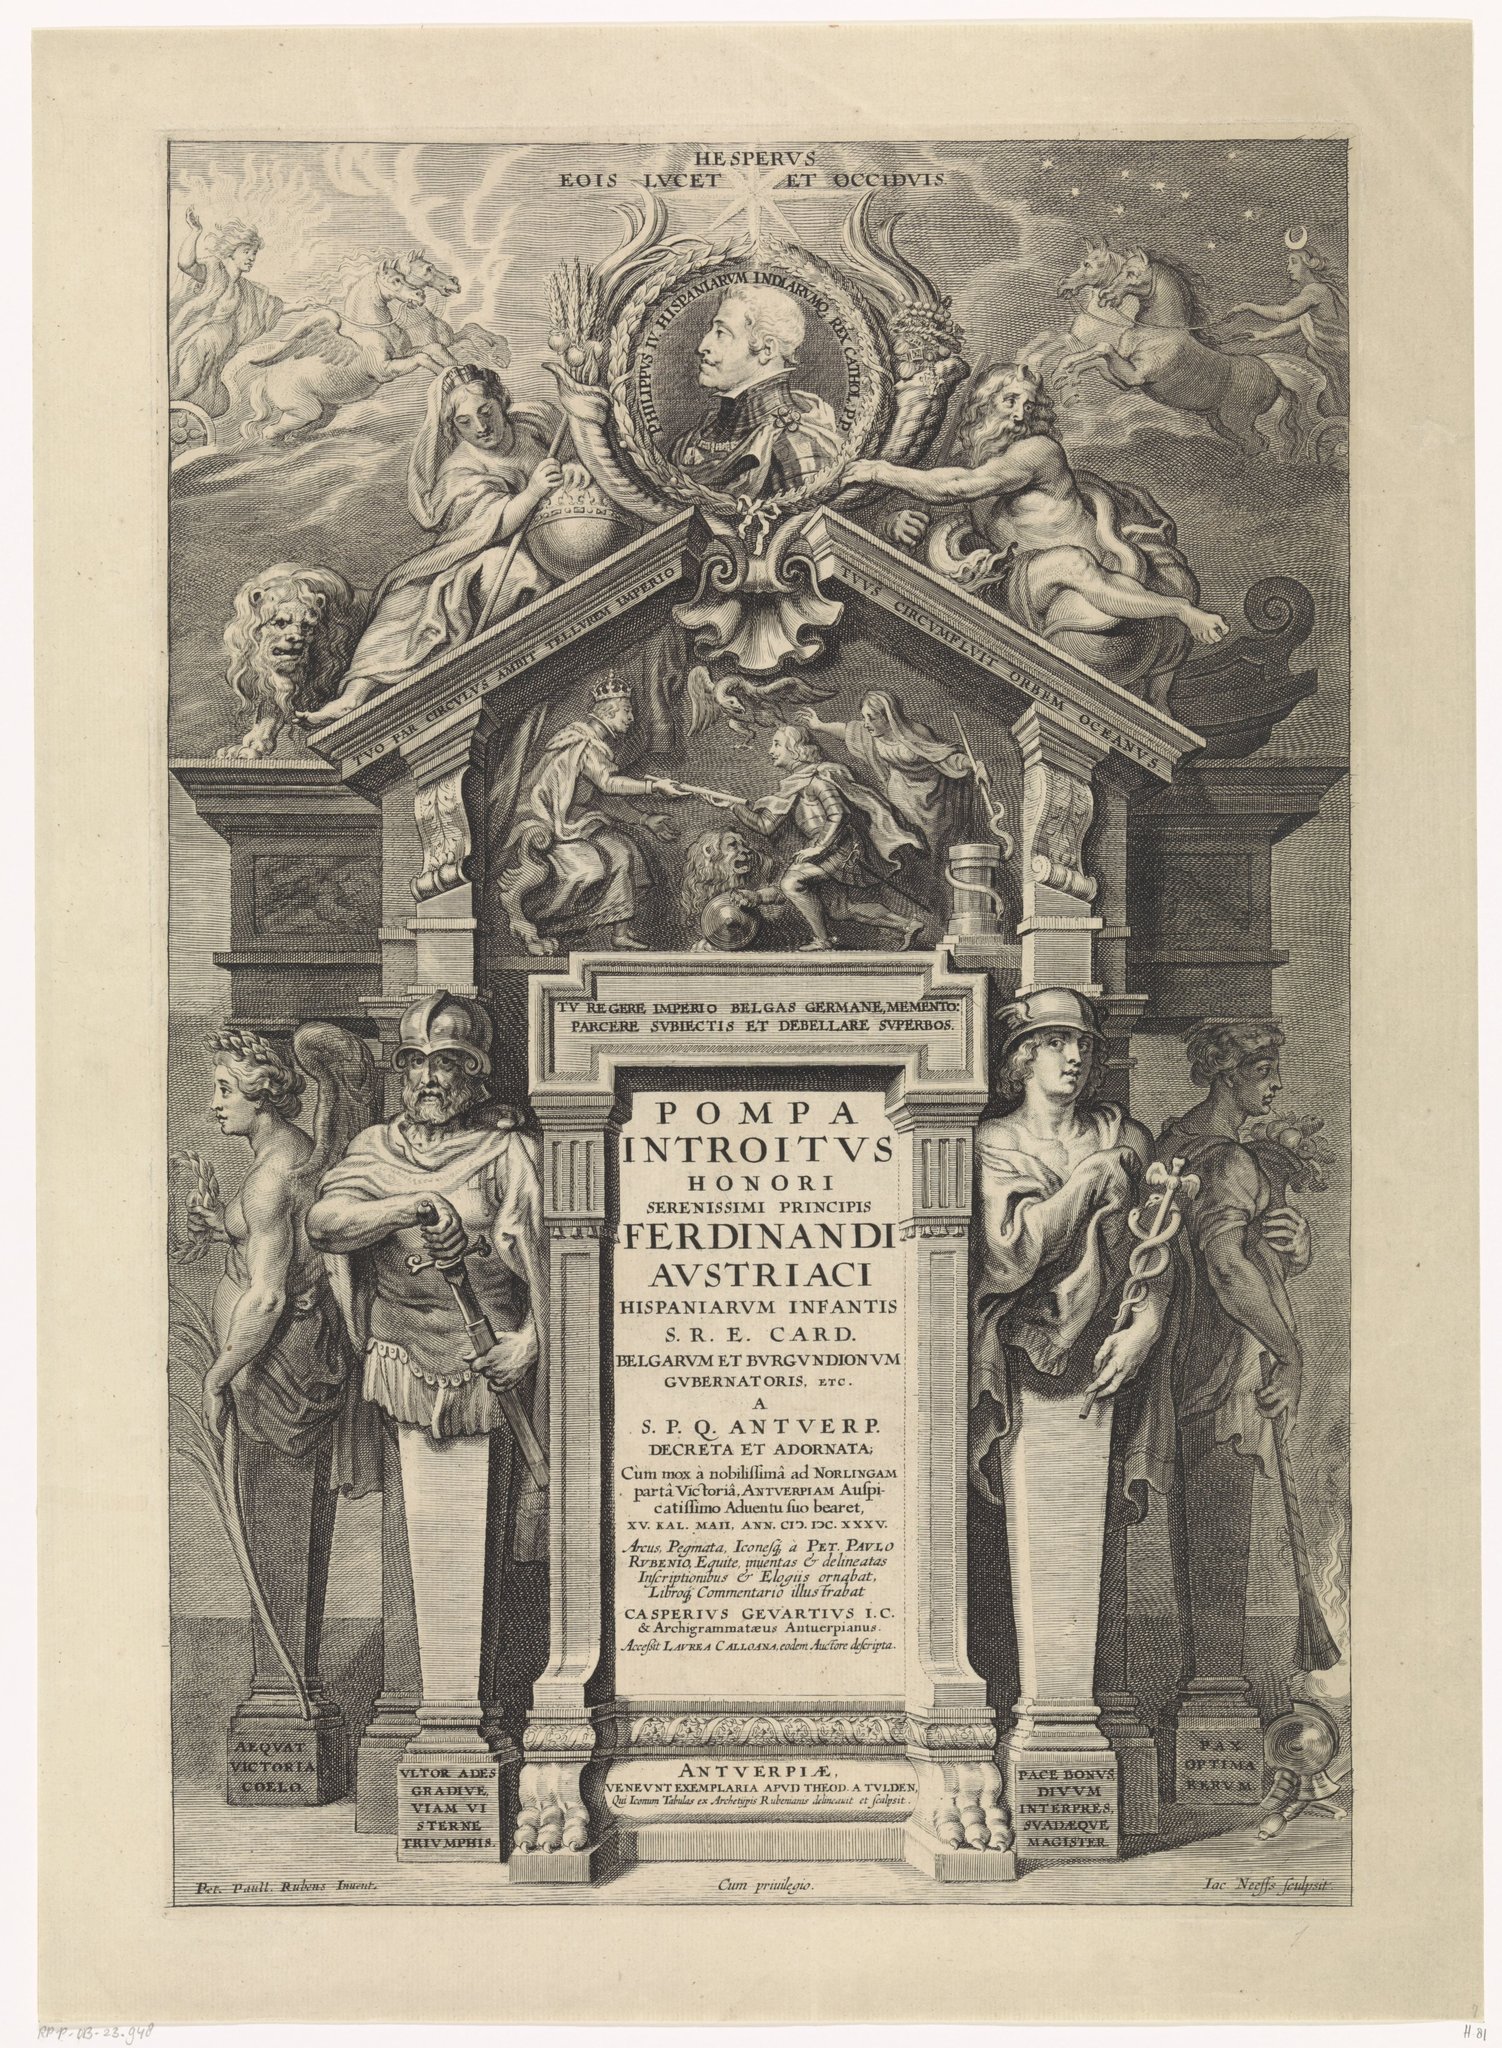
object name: titelblad, titelpagina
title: Allegorie op de komst van Ferdinand van Oostenrijk naar Antwerpen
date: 1642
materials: paper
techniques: engraving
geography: antwerp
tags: filips iv (koning van spanje), brussels, landvoogd der zuidelijke nederlanden ferdinand van oostenrijk, the chariot of the moon, the chariot of the sun, (story of) mars (ares), symbols, allegories of peace, 'pax'; 'pace' (ripa), (story of) mercury (hermes), 'victoria'; 'vittoria', 'vittoria navale', 'vittoria degl'antichi' (ripa)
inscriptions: collector's mark: Lugt 2228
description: Allegorische voorstelling ter ere van de intocht van Ferdinand van Oostenrijk, landvoogd der zuidelijke Nederlanden, op 5 mei 1635 in Antwerpen. Een klassieke tempel wordt bekroond door het portret van Filips IV van Spanje, en profil naar links. Het portret is geplaatst in een ronde lauwerkrans, aan weerszijden geflankeerd door een cornucopia. Op het fronton is te zien hoe Ferdinand van Oostenrijk de scepter krijgt aangereikt van Filips IV. Boven dit tafereel vliegt een adelaar, achter Ferdinand van Oostenrijk staat een vrouw met een staf en kronkelt een slang om een zuil. De vier zuilen van de tempel stellen de Overwinning, Mars, Mercurius en de Vrede voor. Bovenaan de gepersonifieerde zon en maan.